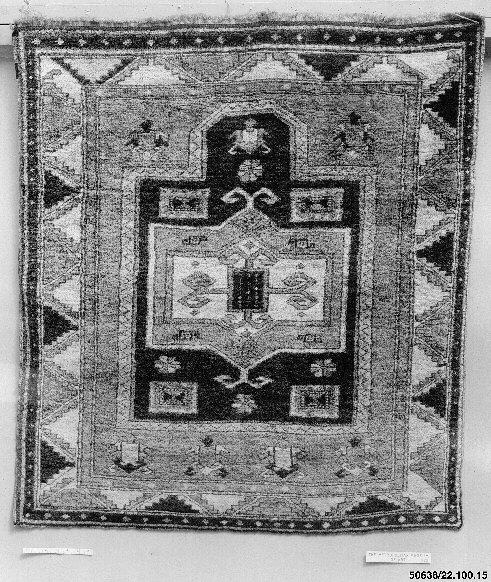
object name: carpet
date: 1834-1866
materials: wool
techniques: pile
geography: south caucasus